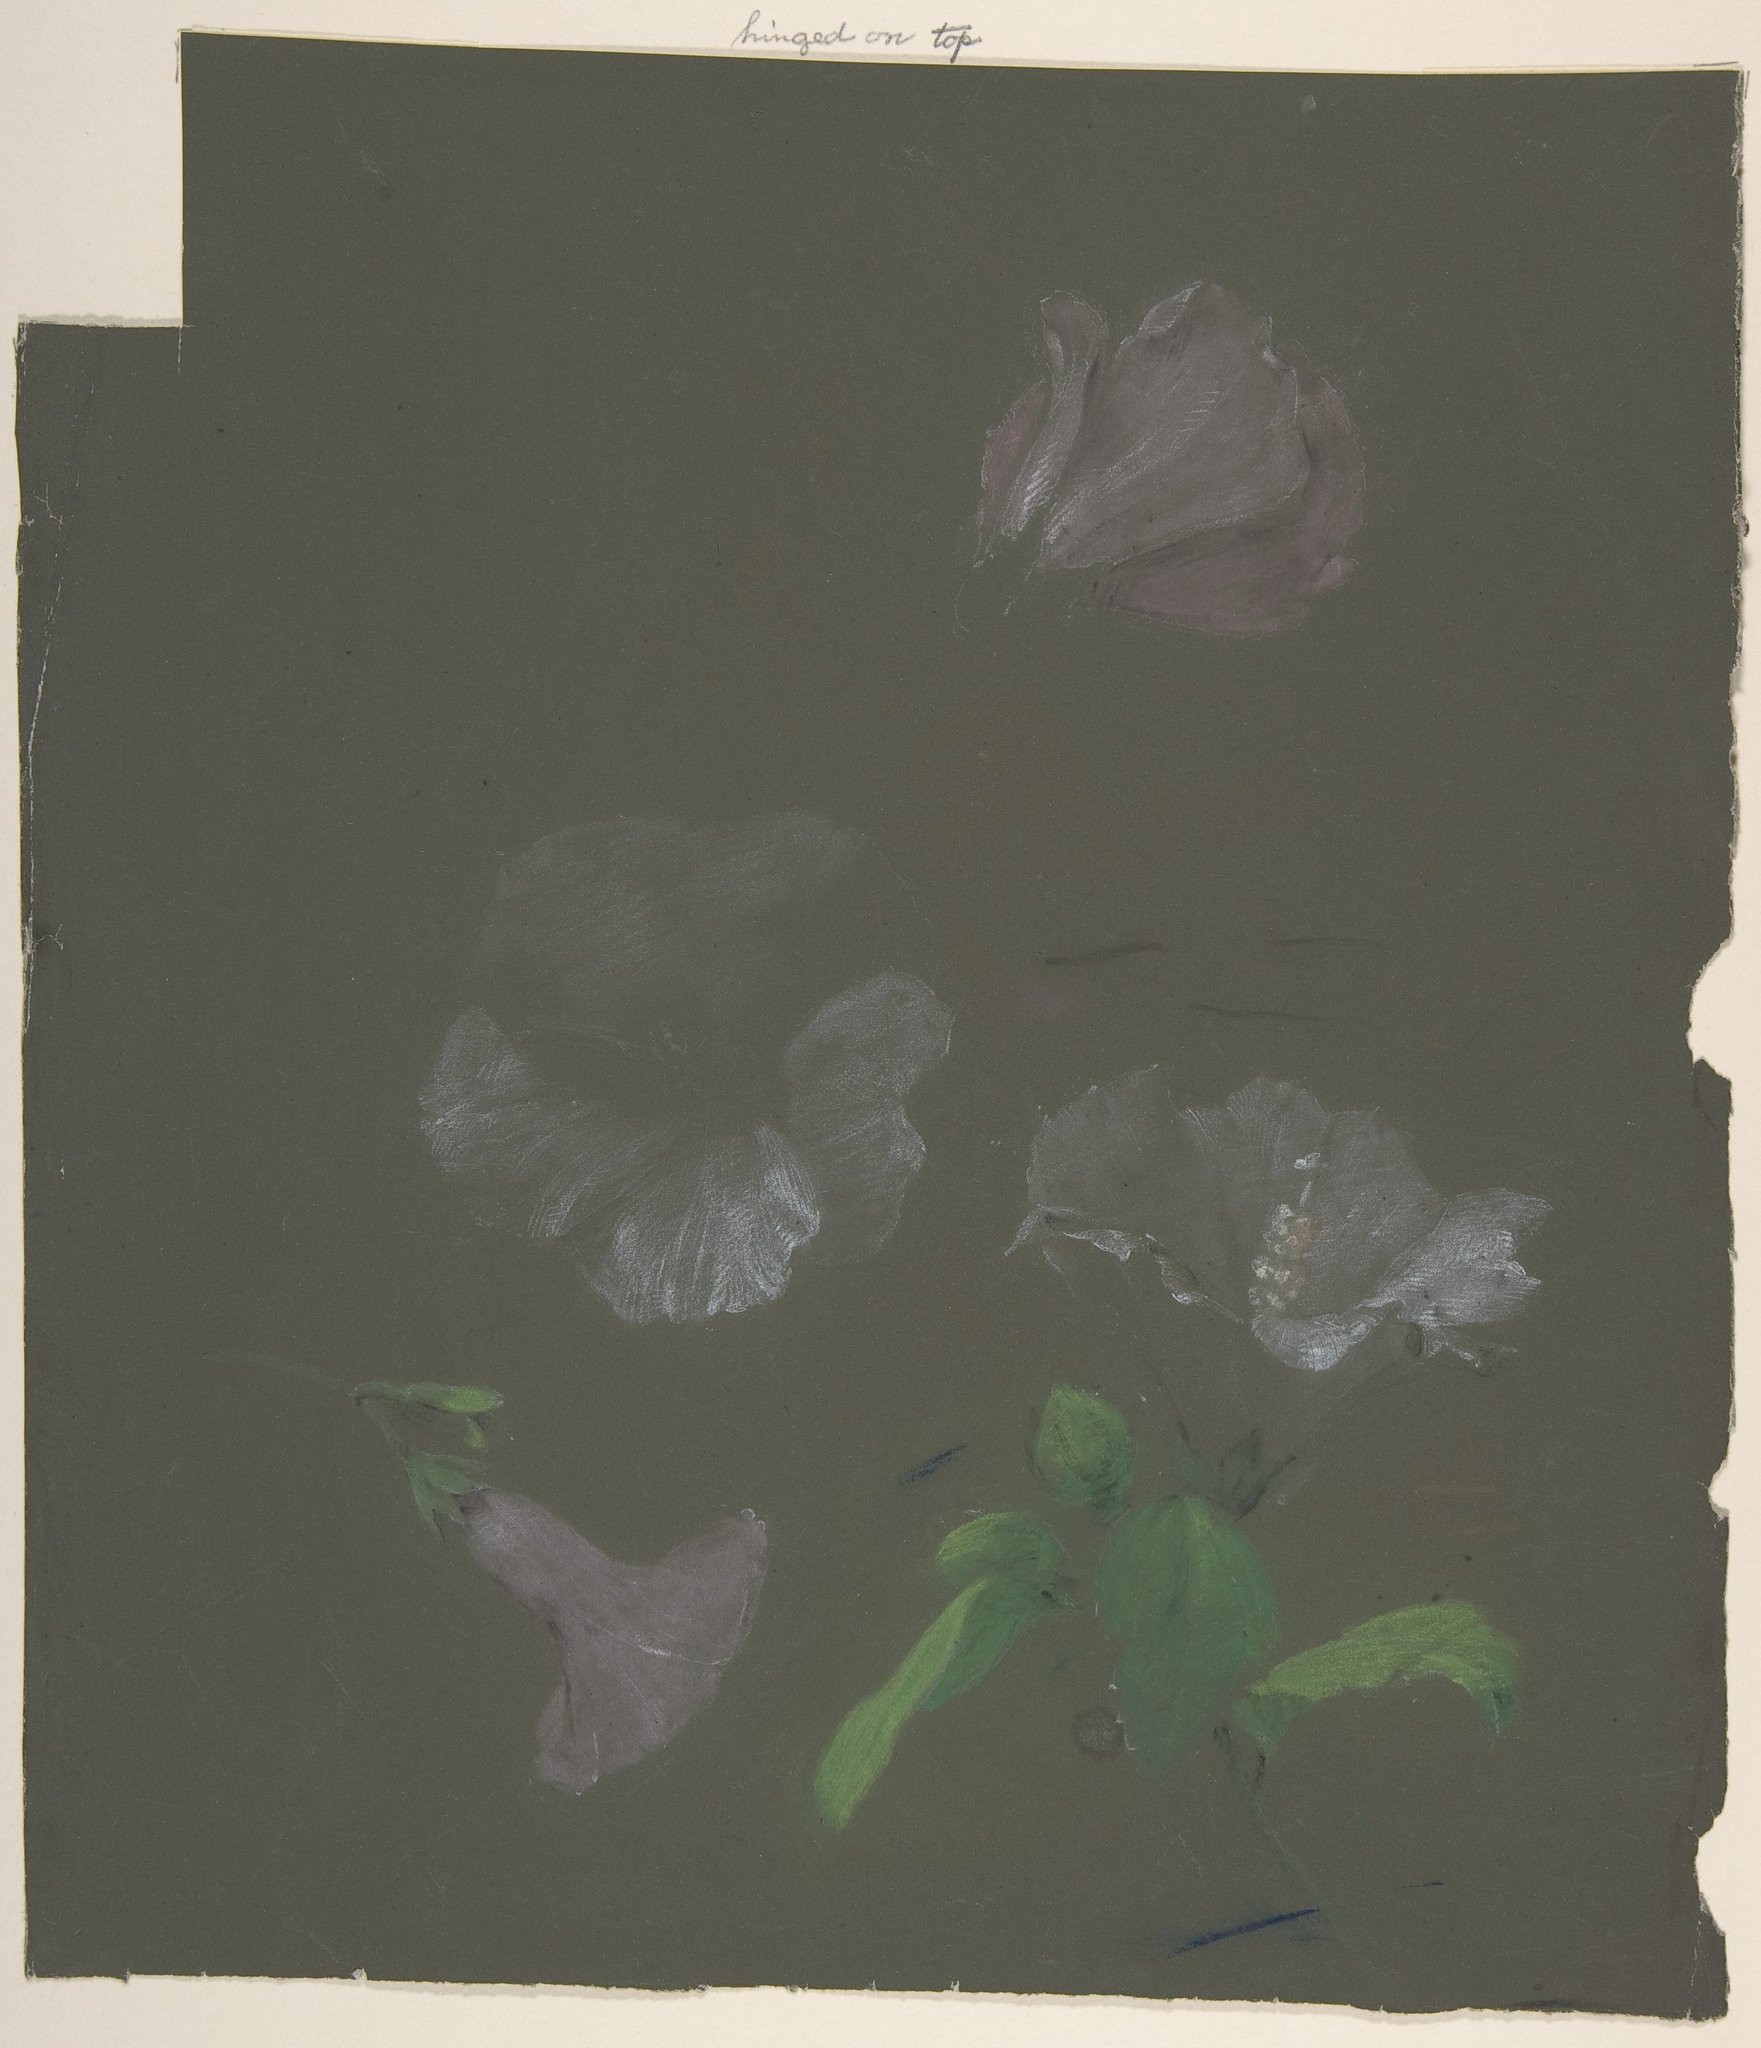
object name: drawing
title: Floral Design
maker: antoine berjon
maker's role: artist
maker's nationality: french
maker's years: 1754-1843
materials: chalk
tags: flowers